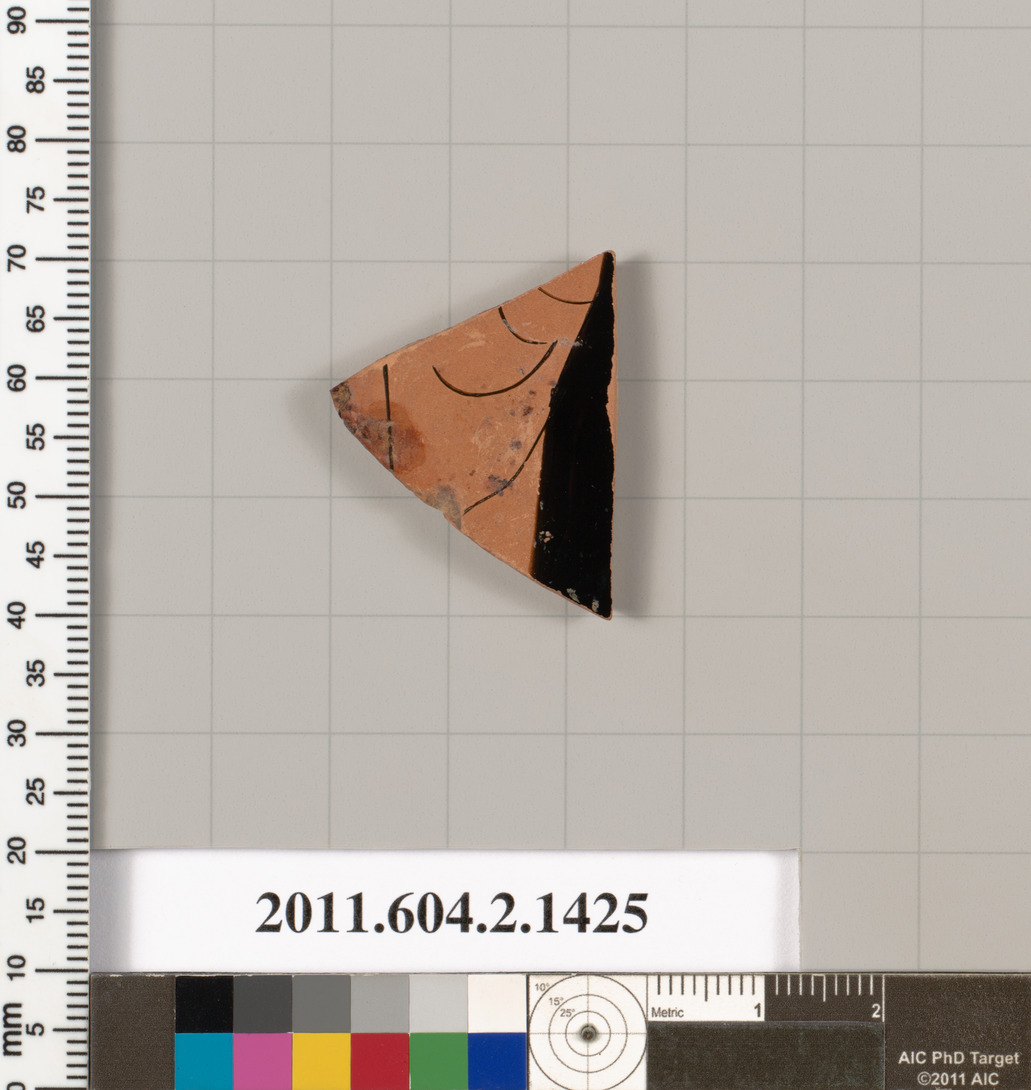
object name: skyphos fragment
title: Terracotta fragment of a skyphos (deep drinking cup)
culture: greek, attic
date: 475-451 BCE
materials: terracotta